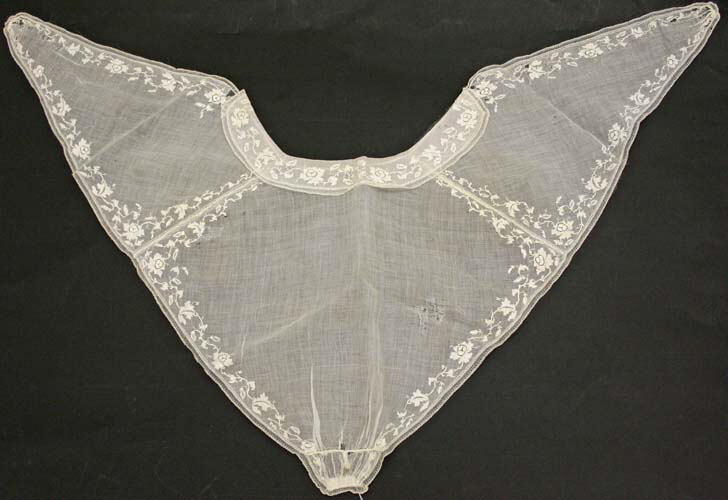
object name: tucker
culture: british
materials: cotton